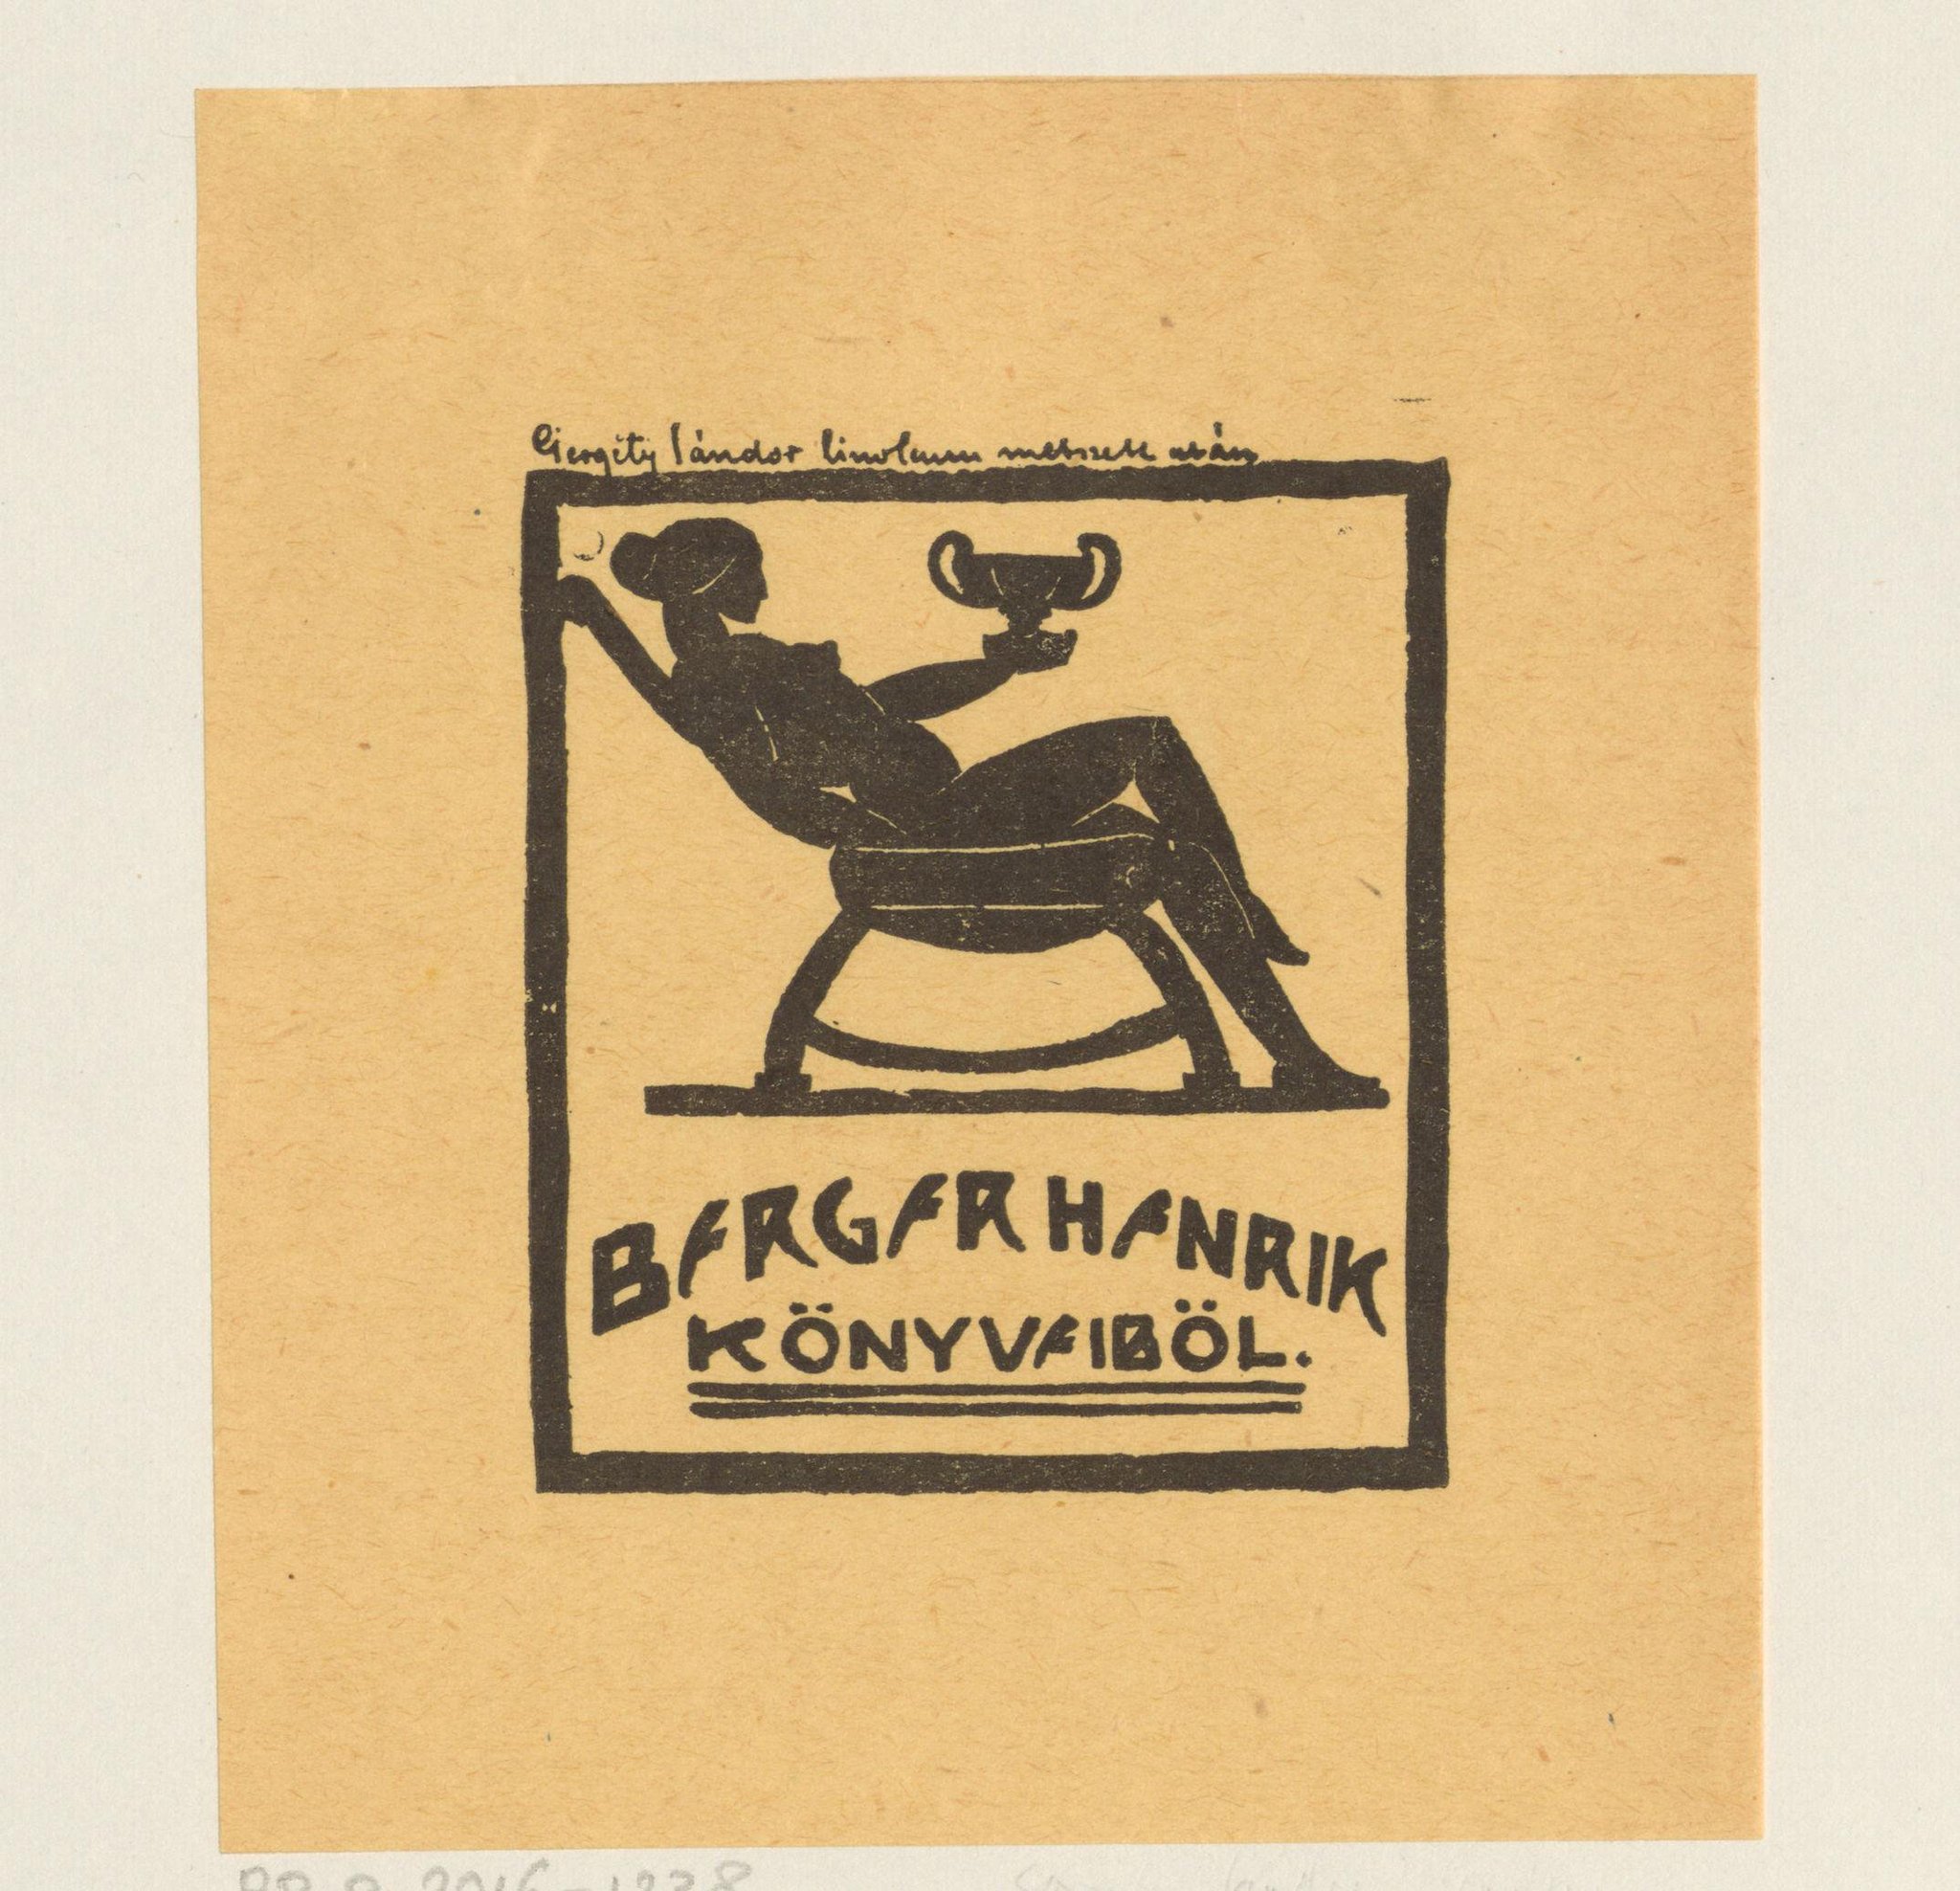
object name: bookplate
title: Ex libris van Berger Henrik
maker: alexander gergely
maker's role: print maker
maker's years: 1888-1932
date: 1899-1932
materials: paper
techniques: linocut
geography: hungary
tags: lying figure - aa - female human figure